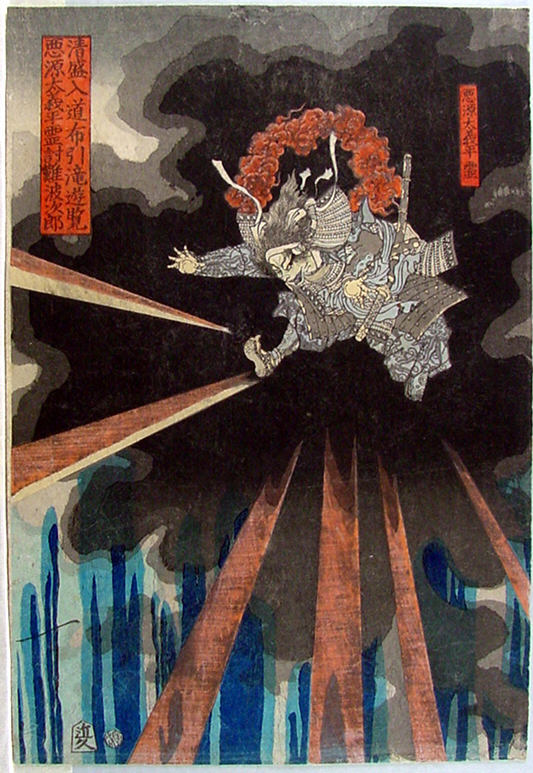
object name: print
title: The Spirit of Akugenta Yoshihira Strikes Nanba Jirō during Kiyomori’s Visit to Nunobiki Waterfall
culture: japanese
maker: tsukioka yoshitoshi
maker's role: artist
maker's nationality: japanese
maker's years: 1839-1892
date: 1868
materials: ink, paper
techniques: nishiki e, woodblock print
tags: swords,men,waterfalls